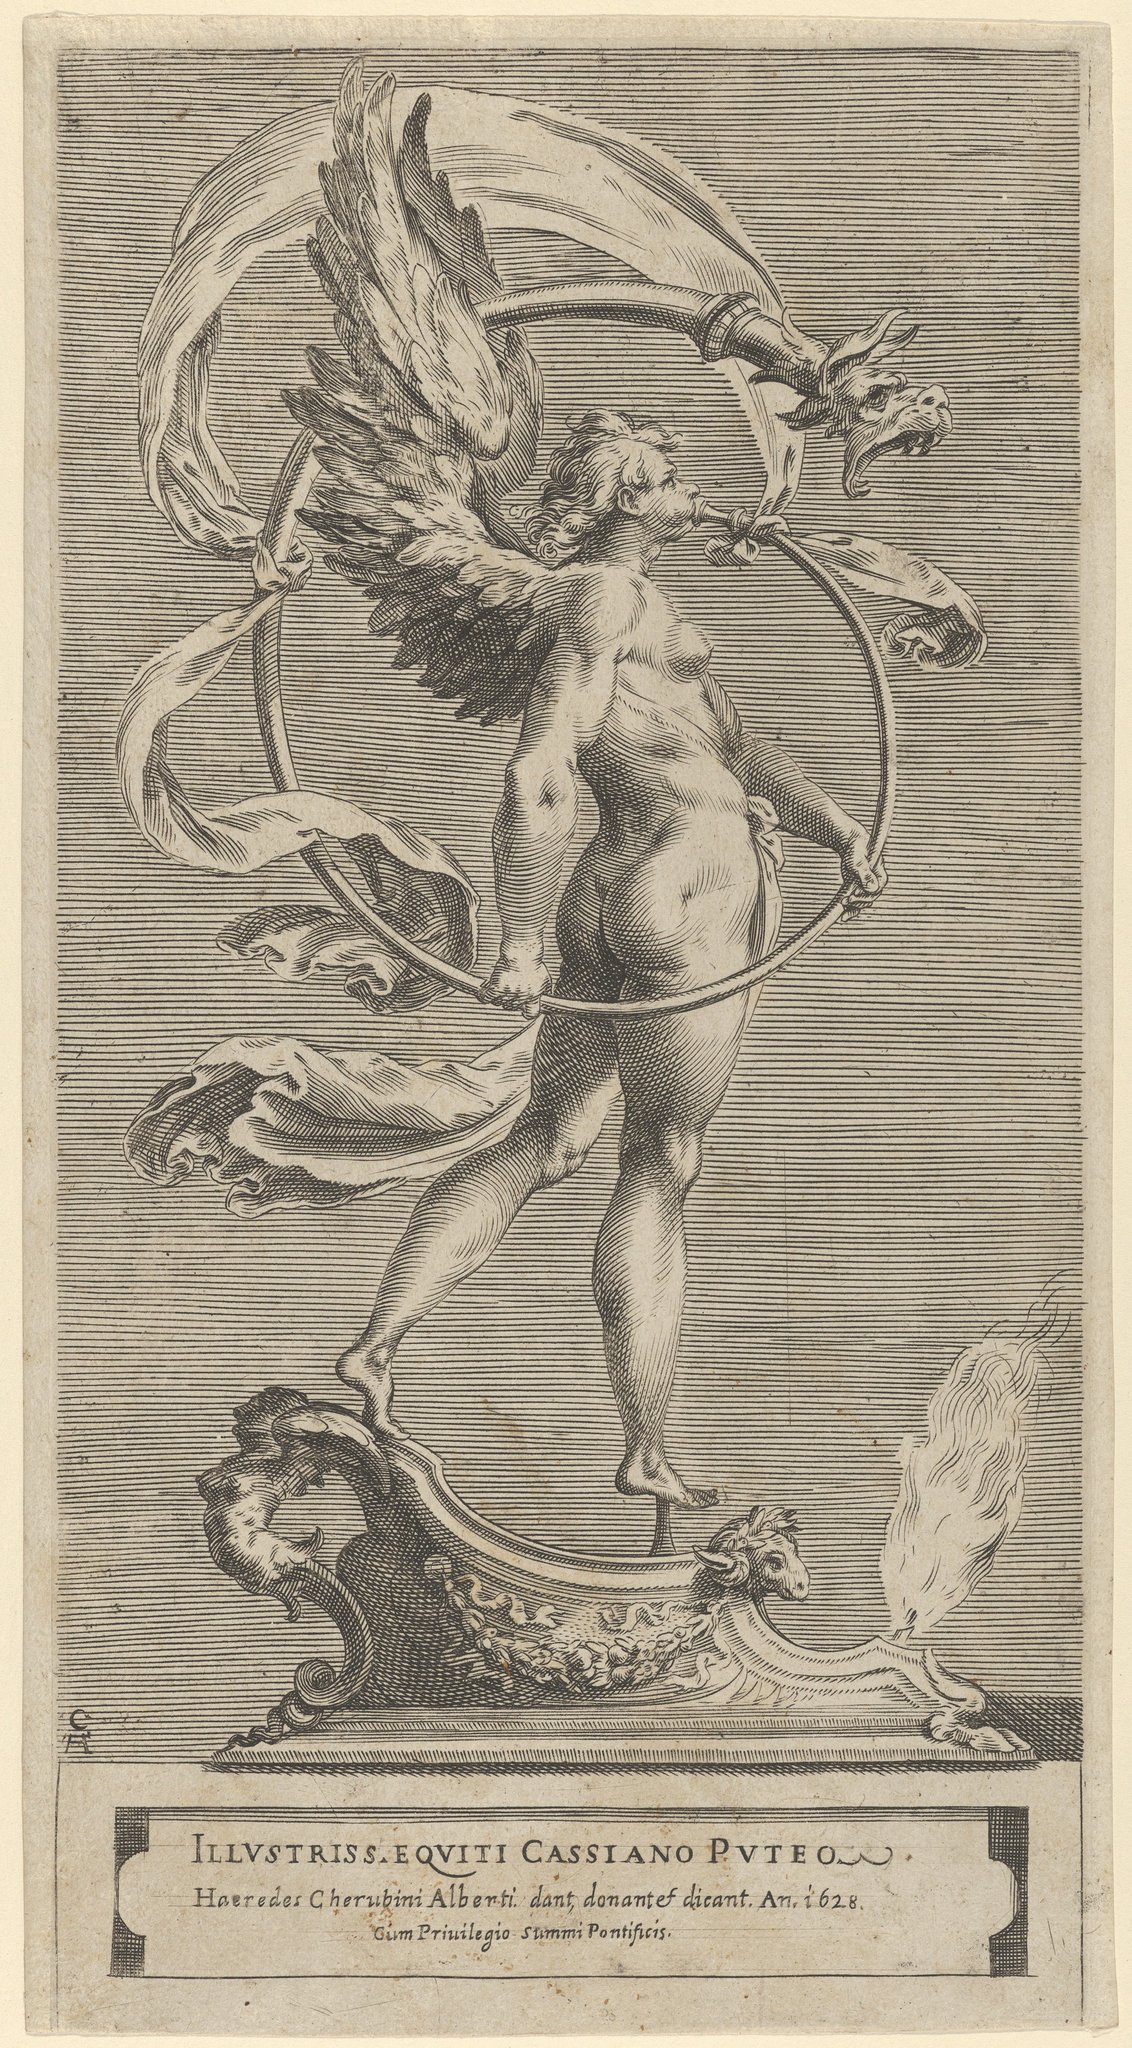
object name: print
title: A winged figure of Fame standing facing left and sounding a trumpet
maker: cherubino alberti (zaccaria mattia)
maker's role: artist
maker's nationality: italian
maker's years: 1553-1615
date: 1570-1615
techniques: engraving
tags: trumpets